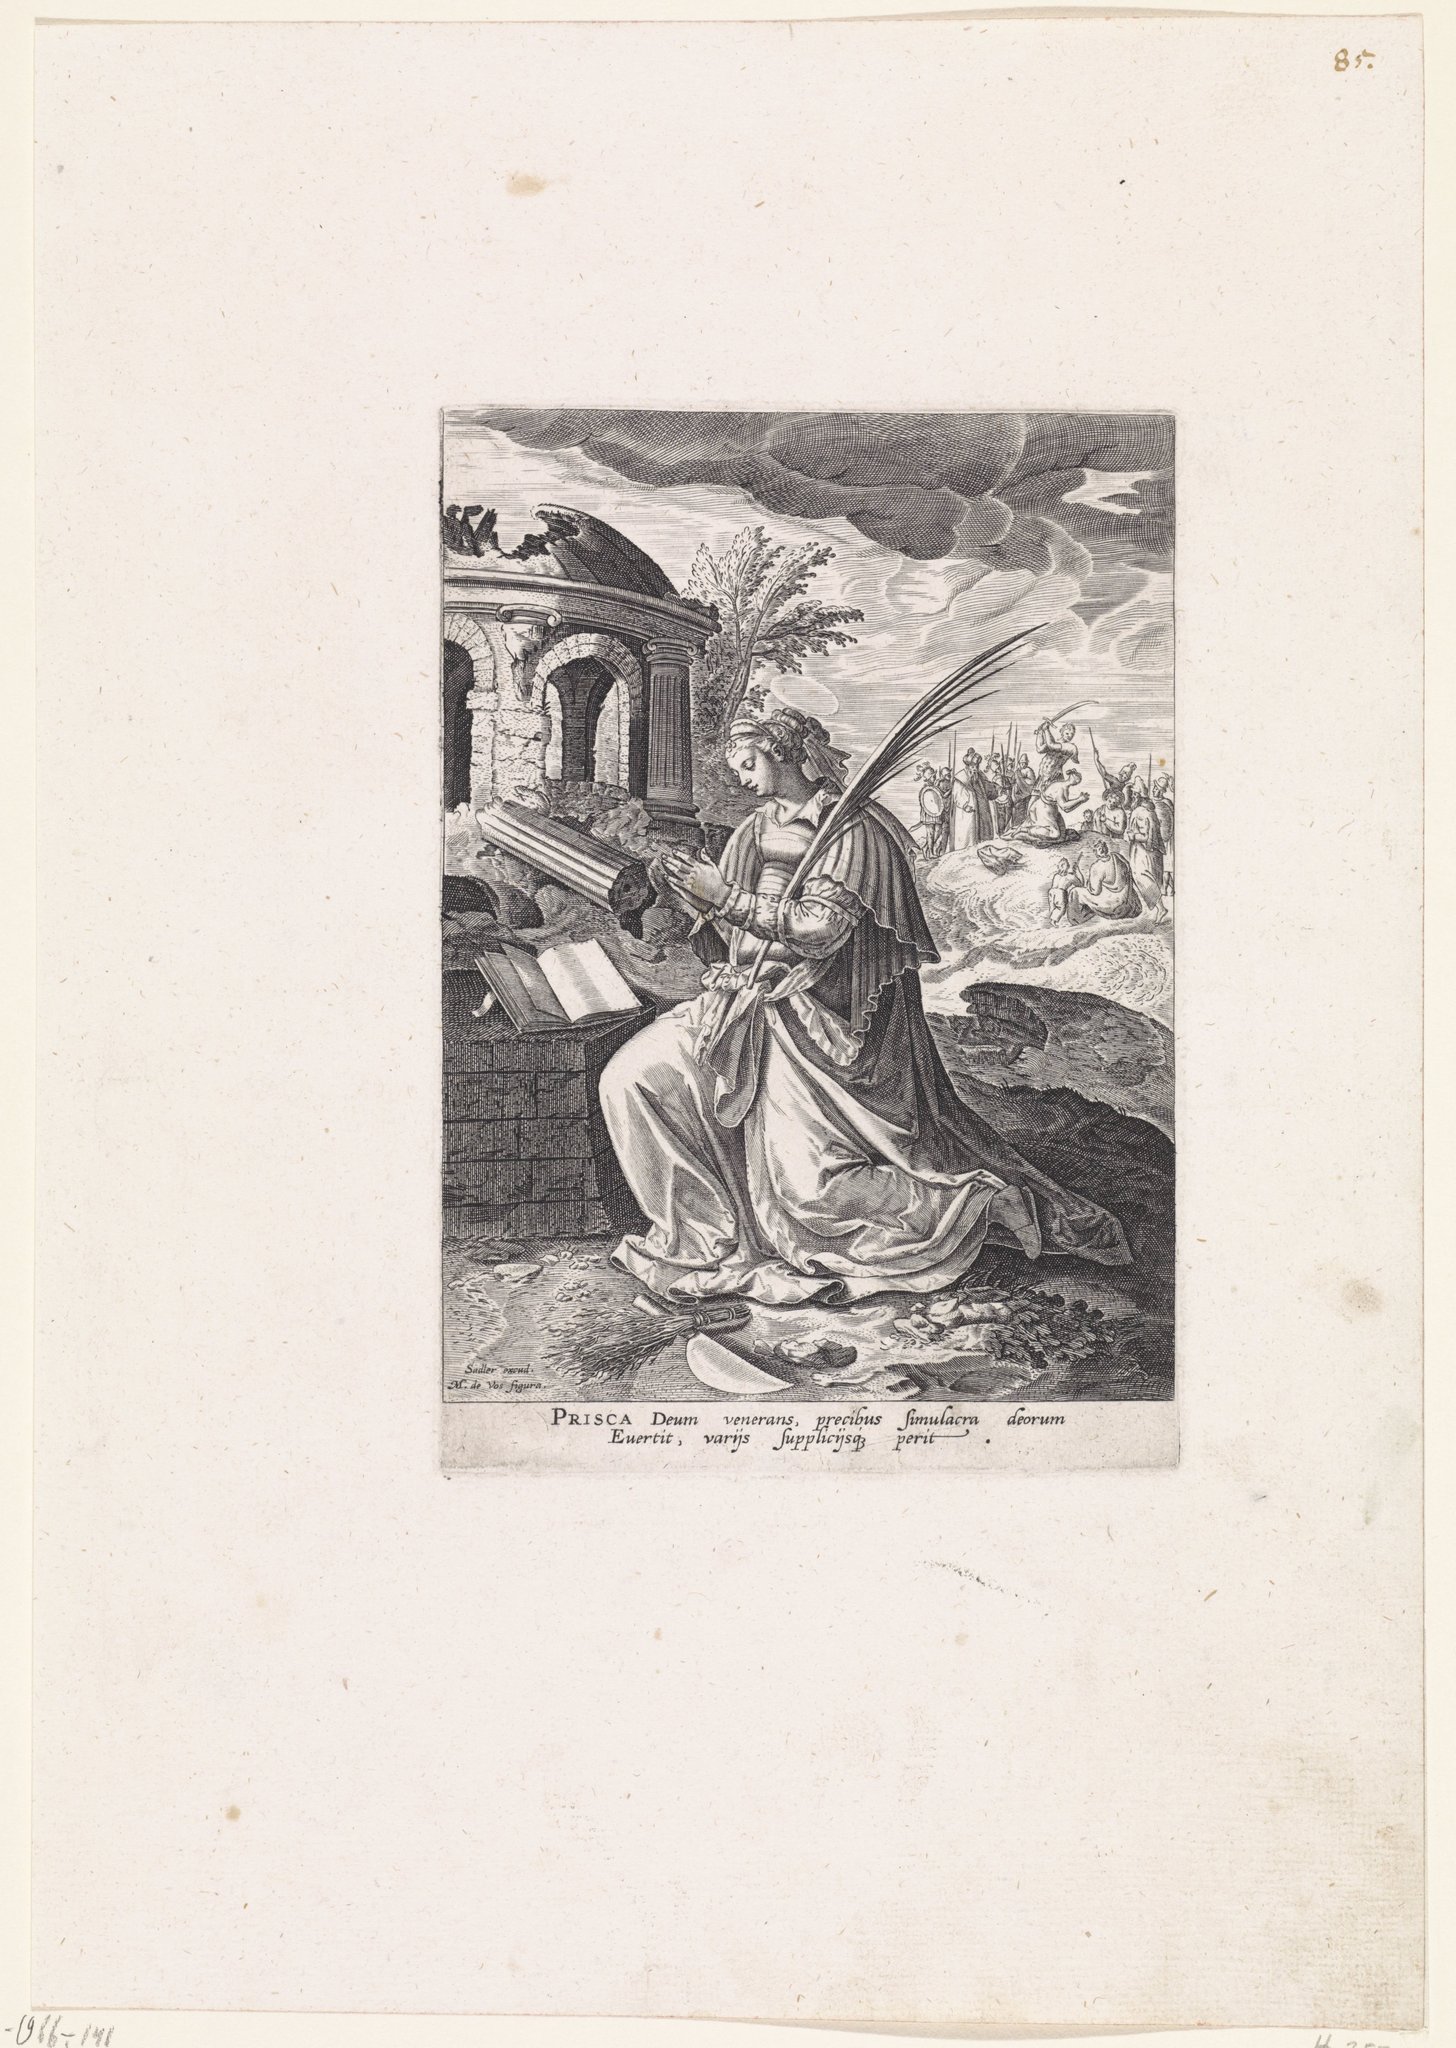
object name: print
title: Heilige Prisca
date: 1583-1587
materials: paper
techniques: engraving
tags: female saints (prisca)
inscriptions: collector's mark: Lugt 2760, number: ‘85’, collector's mark: Lugt 2228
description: De H. Prisca, knielend voor een bijbel. Op de grond voor haar een roede en een bijl. Op de achtergrond rechts wordt de H. Pricia onthoofd. De zestiende prent van een zeventiendelige serie met vrouwelijke heiligen.